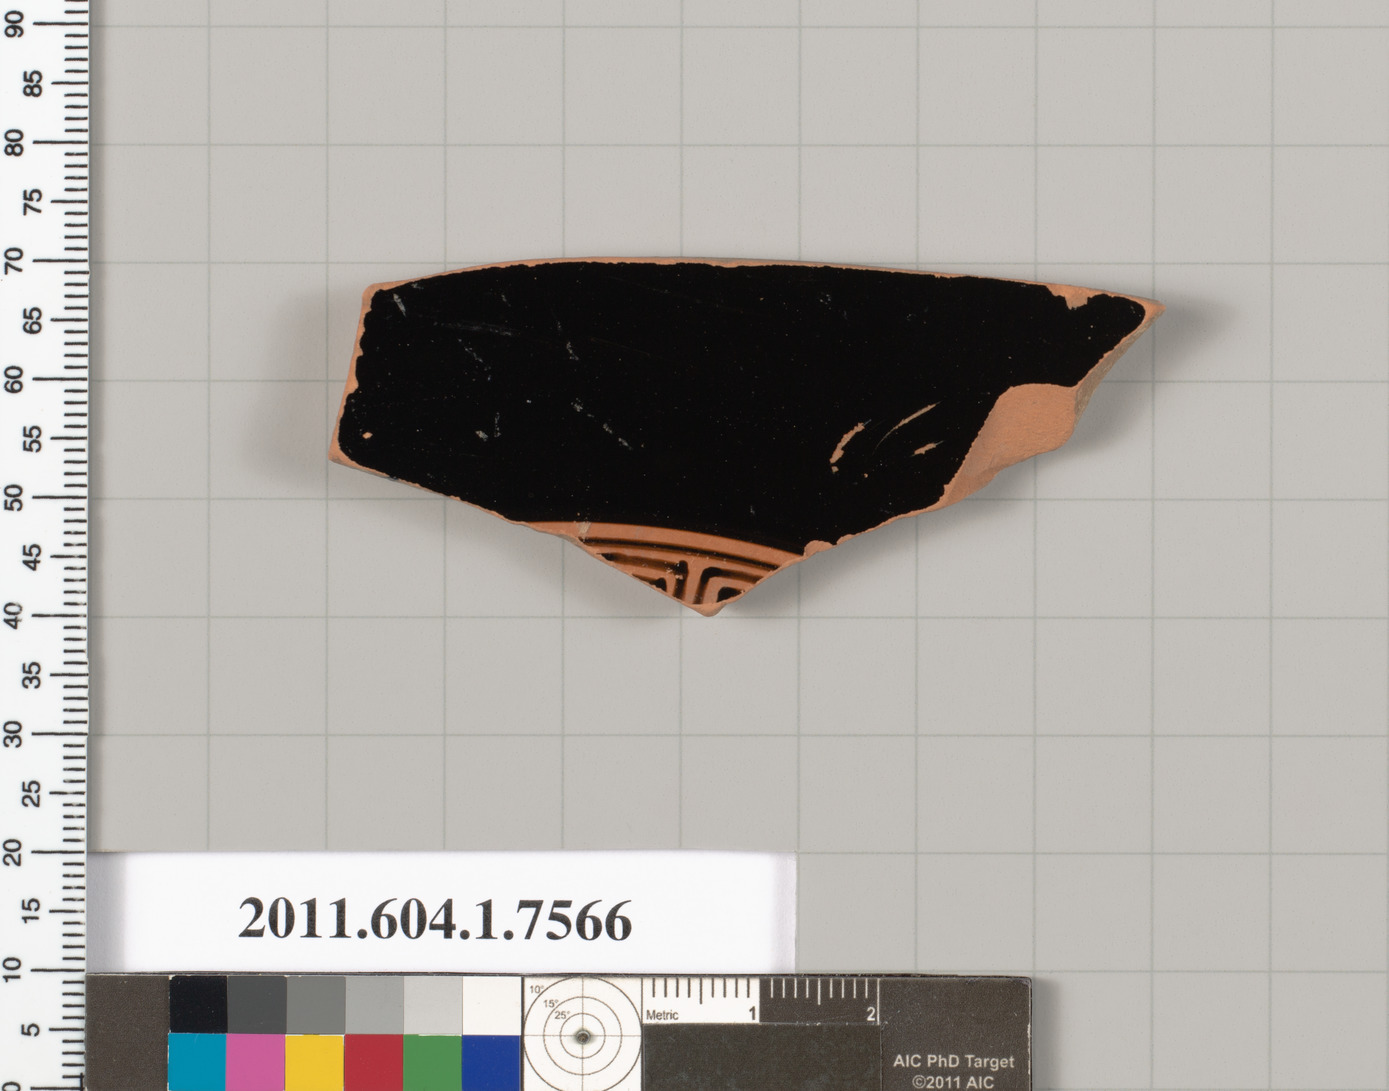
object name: kylix fragment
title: Terracotta fragment of a kylix (drinking cup)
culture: greek, attic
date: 460-450 BCE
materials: terracotta